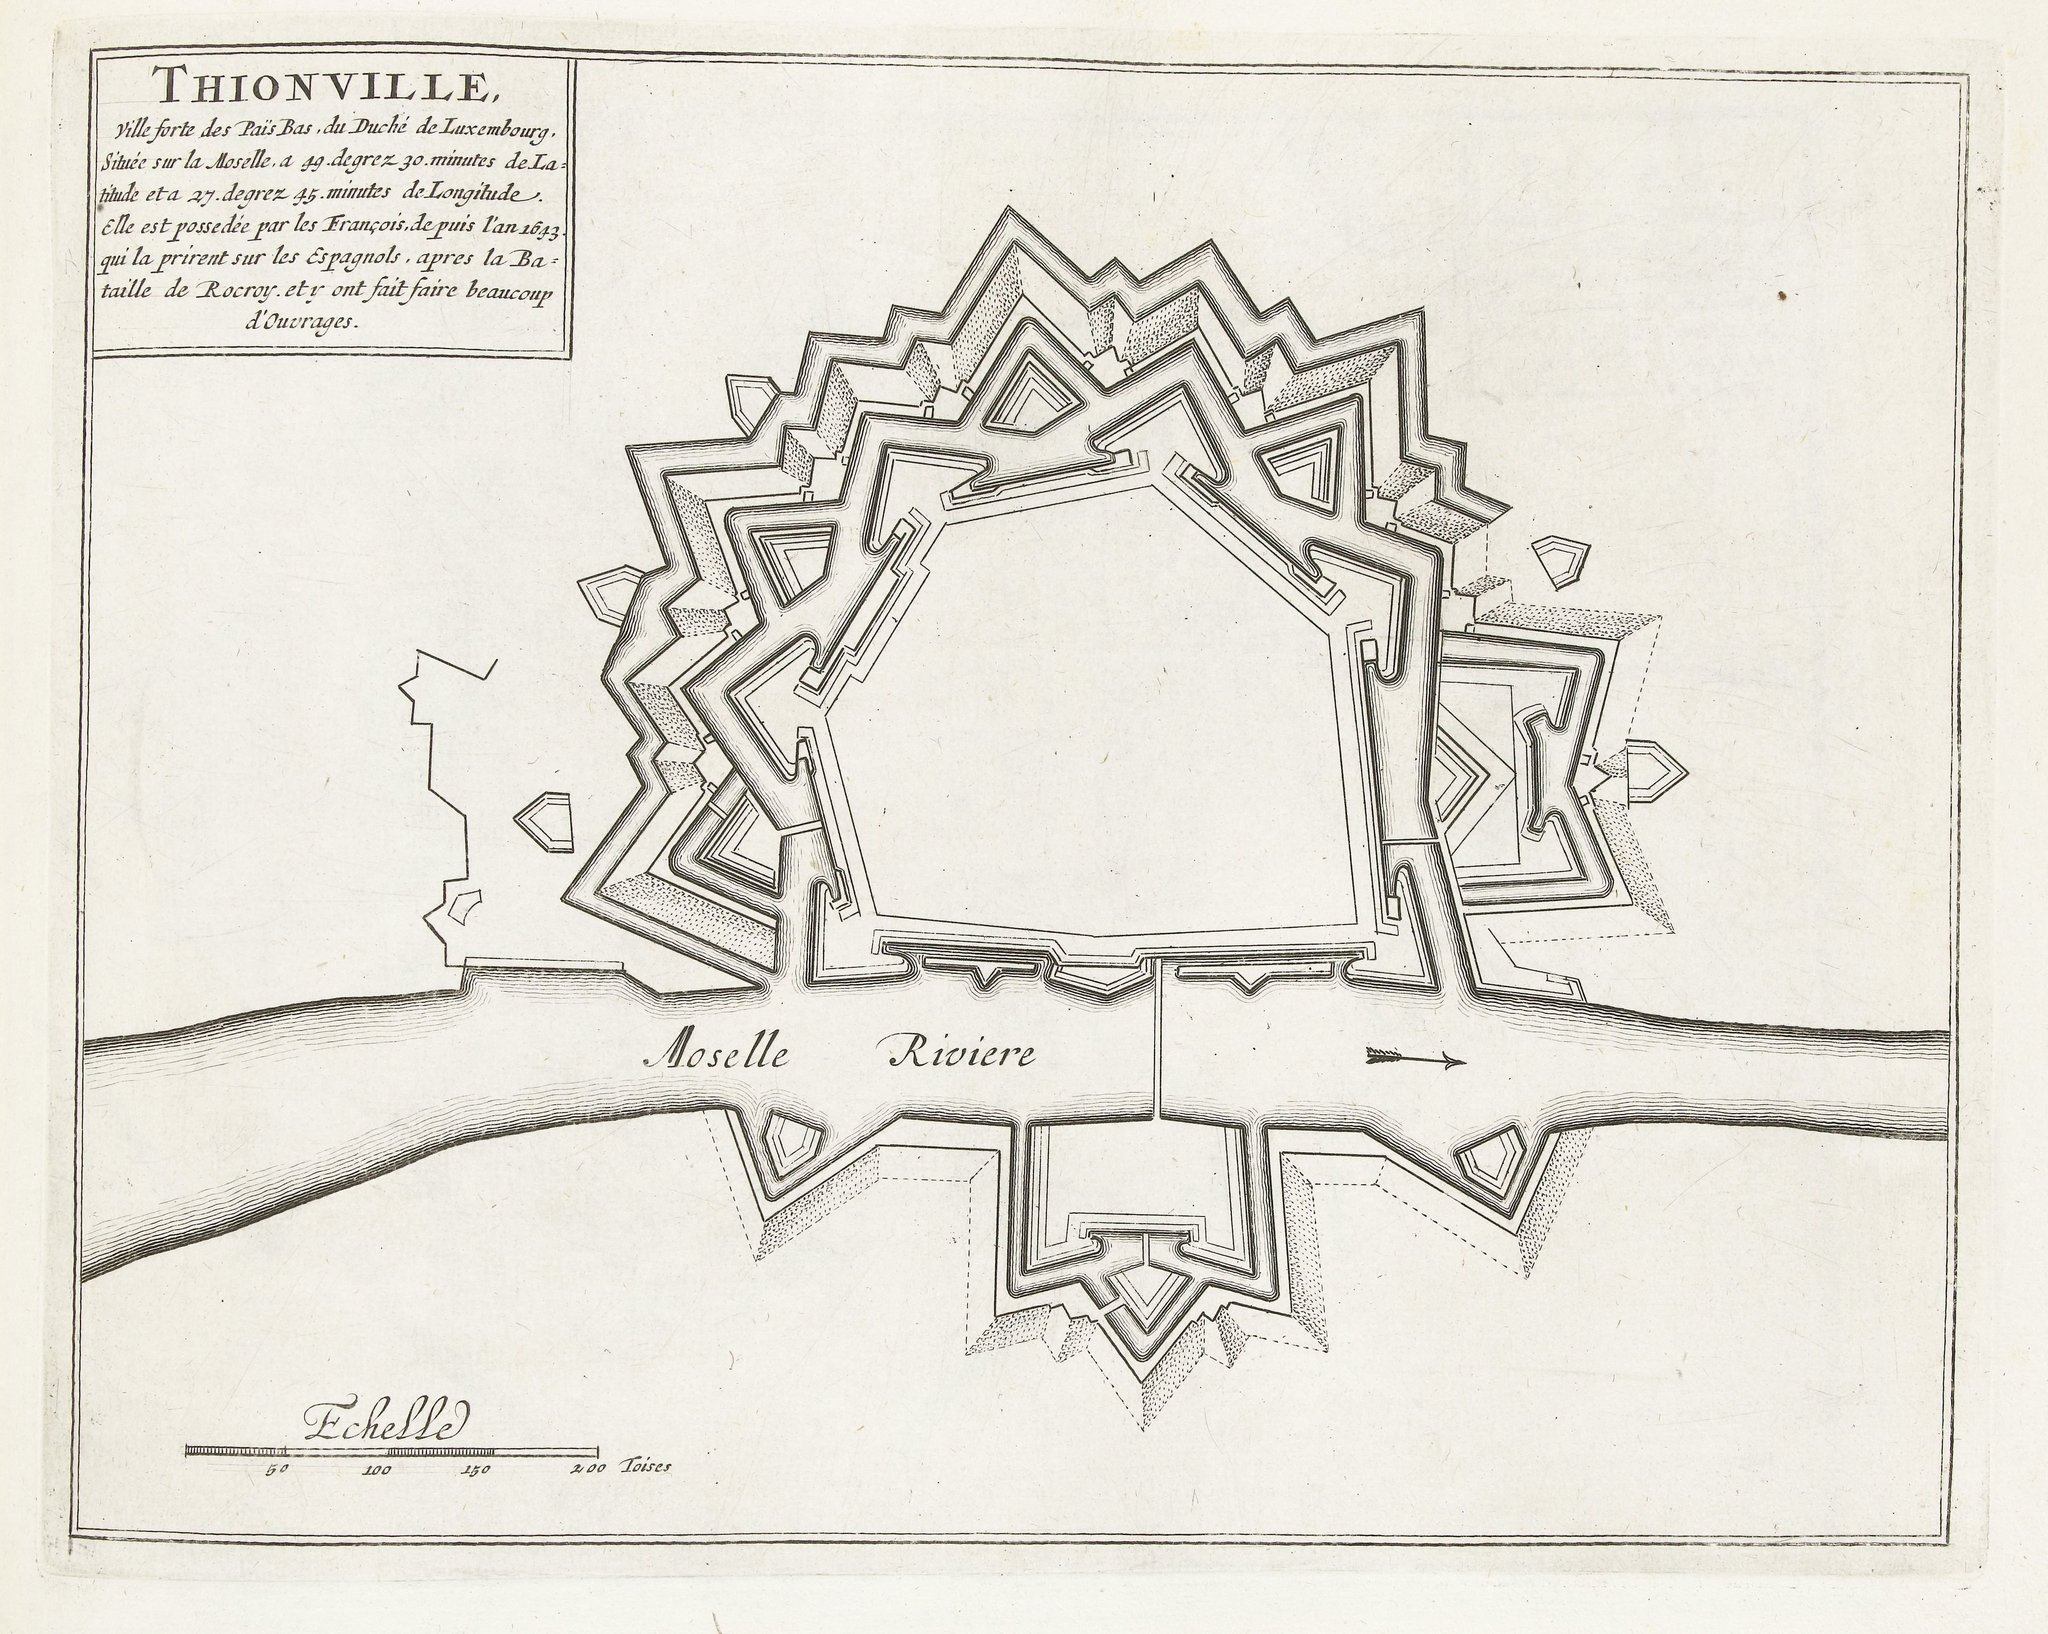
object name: print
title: Plattegrond van Thionville, ca. 1693-1696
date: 1693-1696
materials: paper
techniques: etching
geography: france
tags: fortress, maps of cities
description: Plattegrond van de versterkingen om de Luxemburgse stad Thionville, tegenwoordig in Frankrijk. Onderdeel van het zevende deel (1696) van het prentwerk waarin gebundeld zijn de acht delen van Les forces de l'Europe uitgegeven tussen 1693-1697. Het prentwerk bestaat uit 175 platen met plannen (afkomstig van Sébastien Le Prestre, Seigneur de Vauban) van vermaarde sterke steden en vestingen in de Negenjarige Oorlog. Titel en opschriften in het Frans.